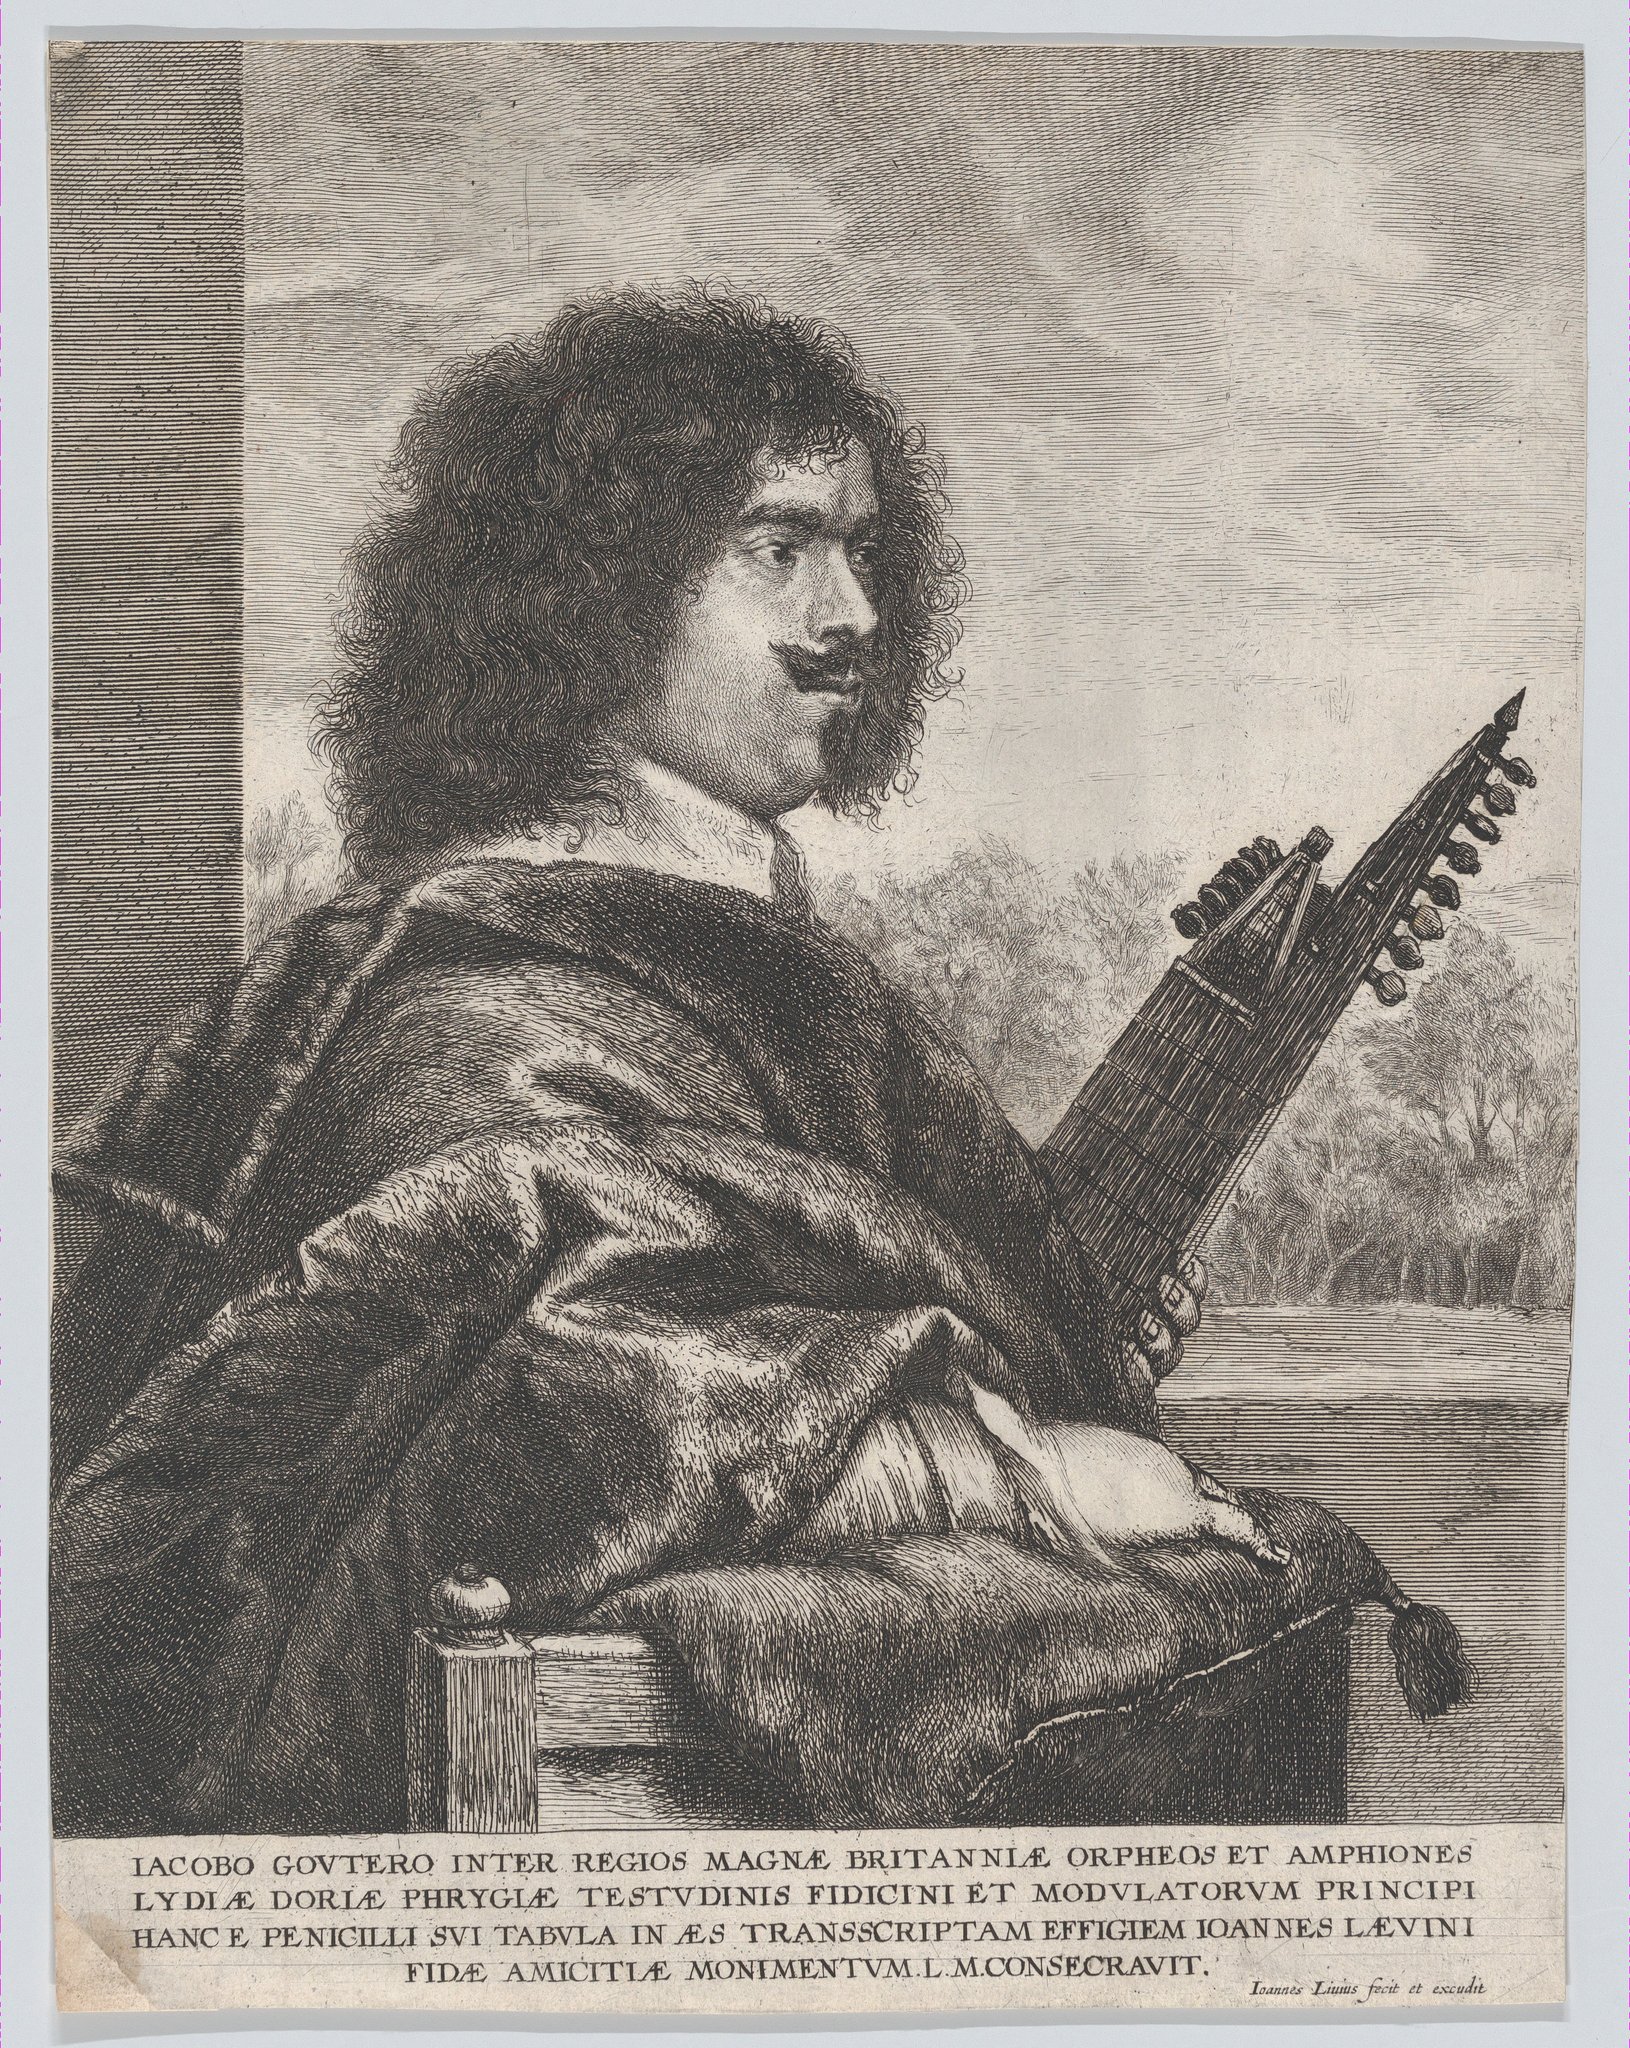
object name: print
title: Jacques Gaultier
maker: jan lievens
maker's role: artist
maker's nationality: dutch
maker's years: 1607-1674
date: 1601-1700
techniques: etching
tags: musical instruments,men,portraits